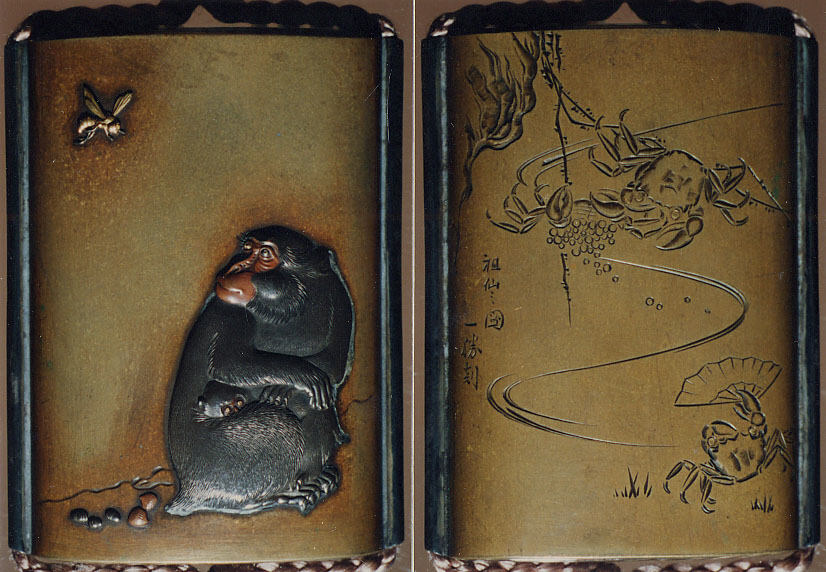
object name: inrō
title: Case (Inrō) with Design of Seated Monkey Looking at a Wasp (obverse); Crabs with Fan beside Waves (reverse)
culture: japanese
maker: mori sosen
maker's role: artist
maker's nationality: japanese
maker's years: 1747-1821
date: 1801-1900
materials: brass, metal, silver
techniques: incising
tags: crabs,insects,monkeys